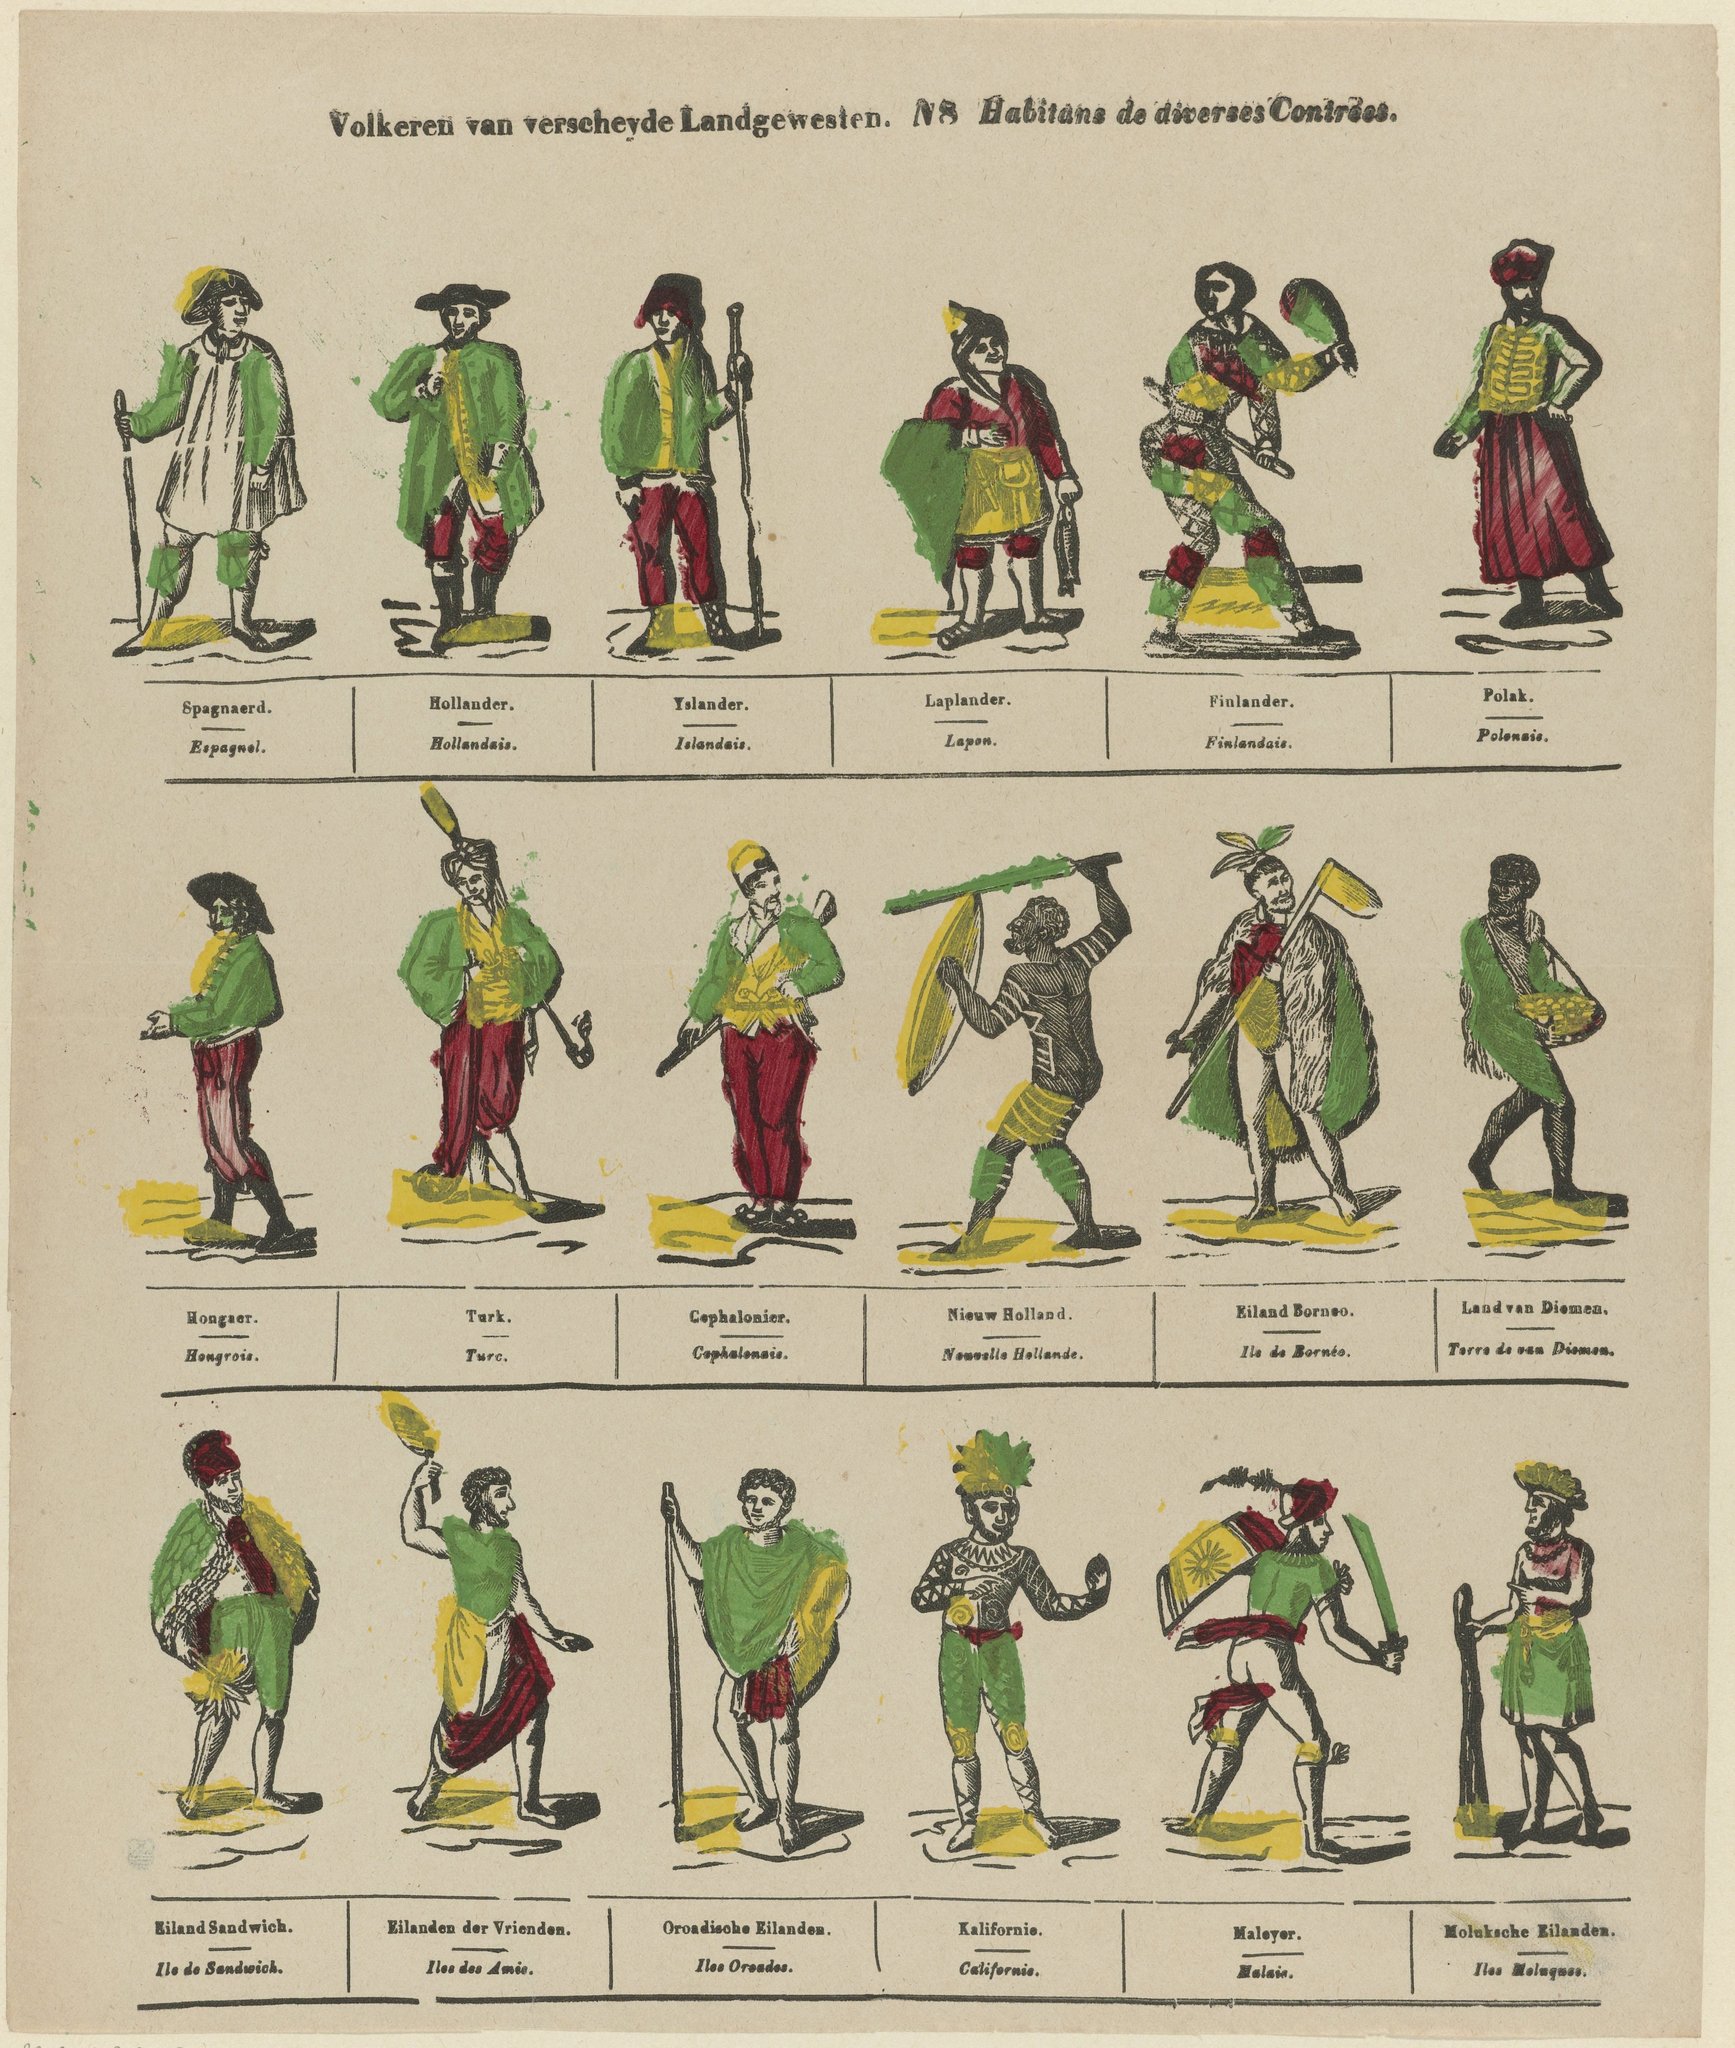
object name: print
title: Volkeren van verscheyde landgewesten / Habitans de diverses Contrées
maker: Anonymous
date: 1833-1856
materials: paper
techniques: colour, letterpress printing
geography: turnhout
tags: human races; peoples; nationalities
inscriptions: collector's mark: Lugt 2760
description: Blad met 3 horizontale rijen met in totaal 18 voorstellingen van mensen uit verschillende landen, zoals een Hollander, een Laplander, een Turk en een Pool. Onder elk figuur een onderschrift in het Nederlands en in het Frans. Genummerd midden boven: N8.